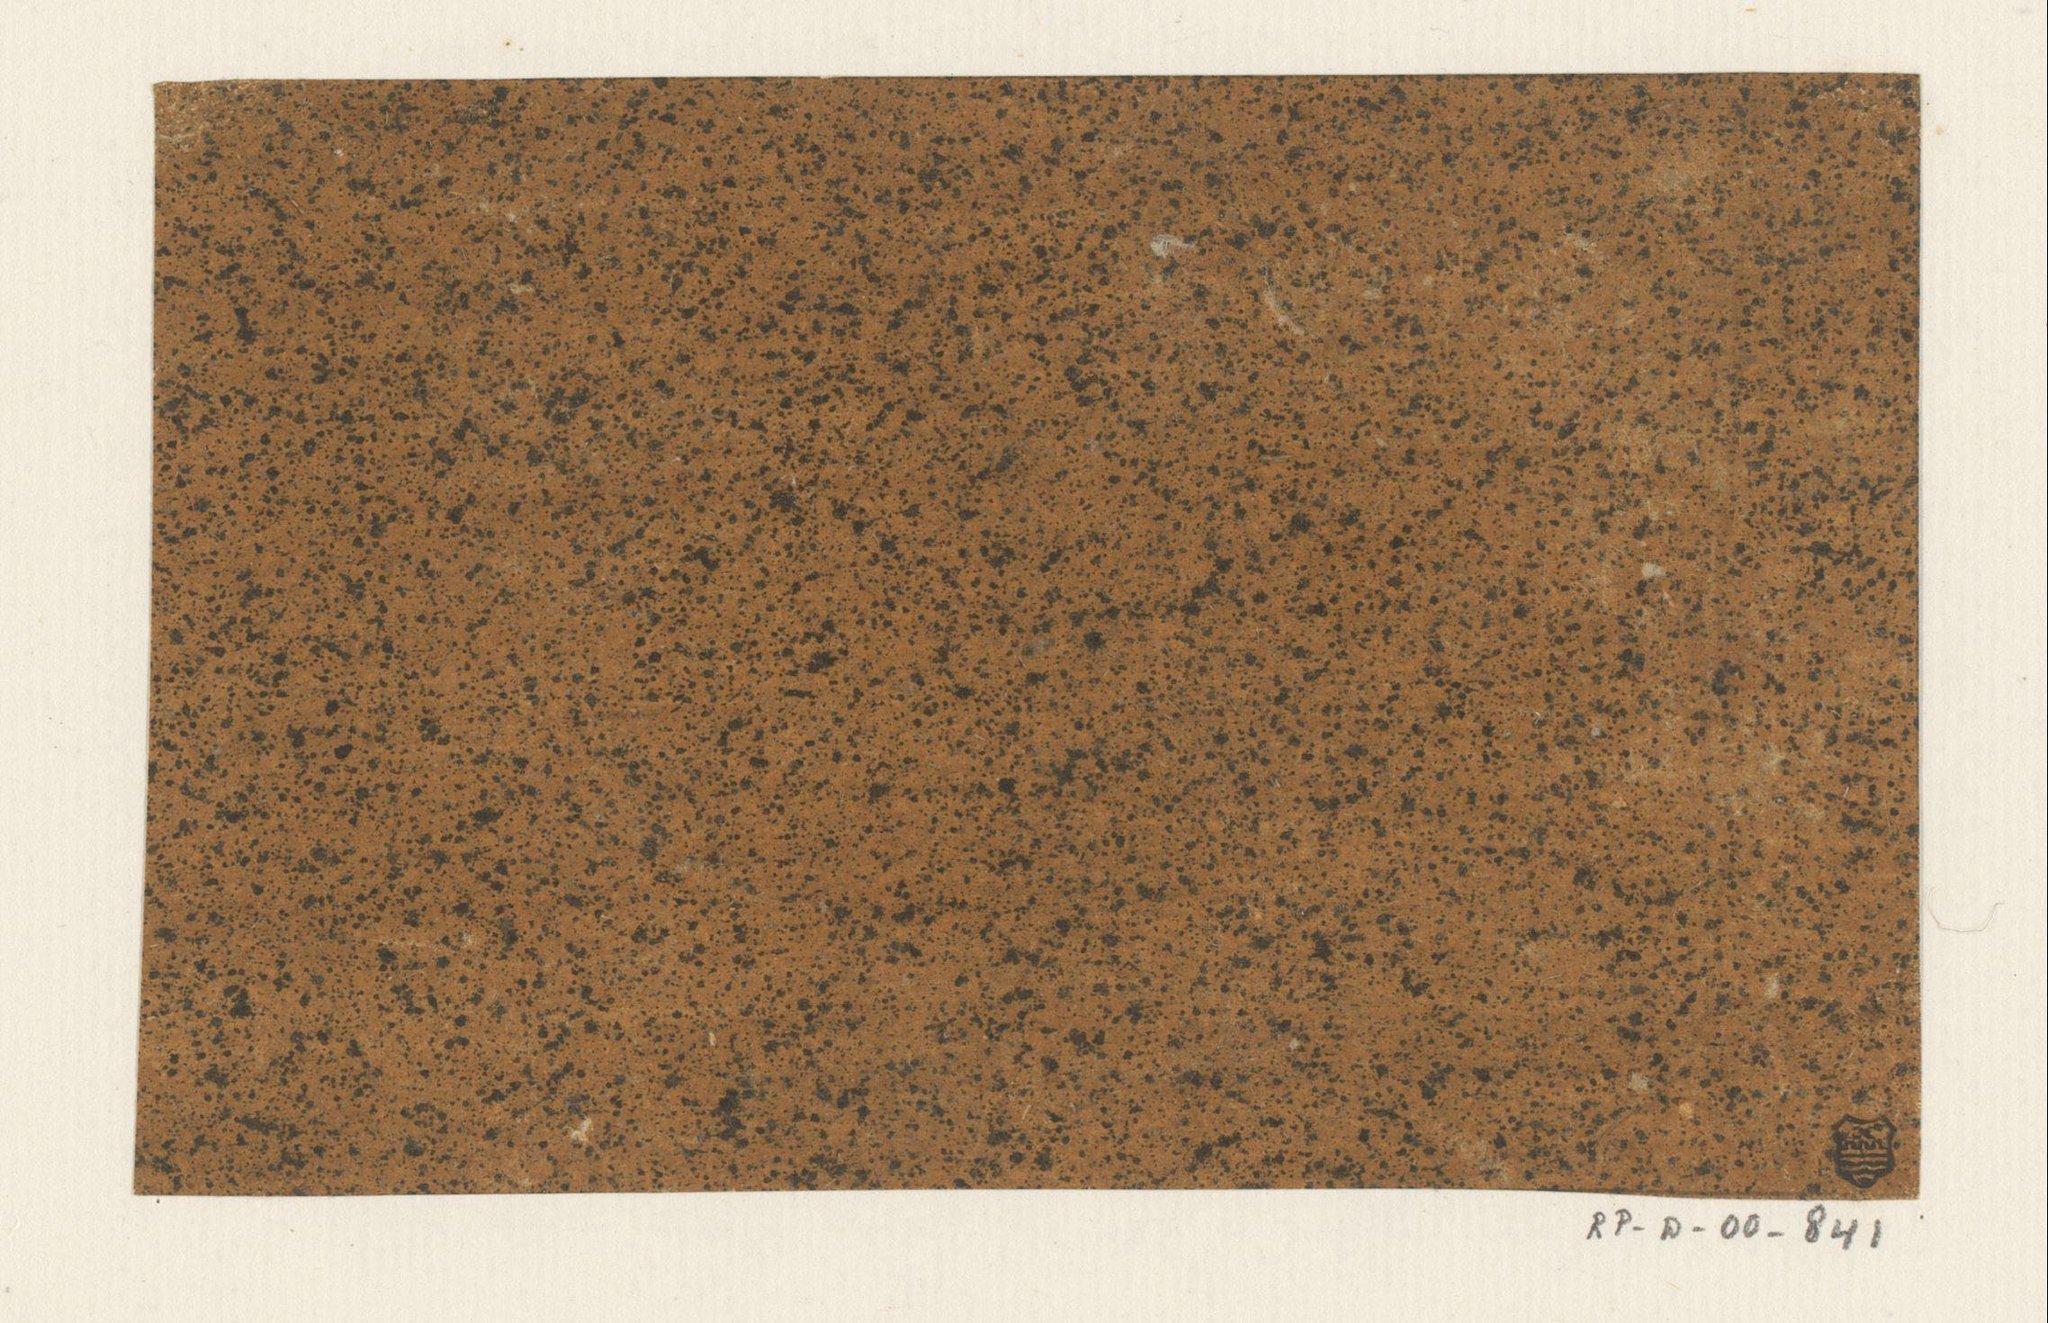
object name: sprinkled paper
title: Zwart gespikkeld bruin papier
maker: Anonymous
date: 1750-1900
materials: paper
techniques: kievitsmarmer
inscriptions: collector's mark: Lugt 2760